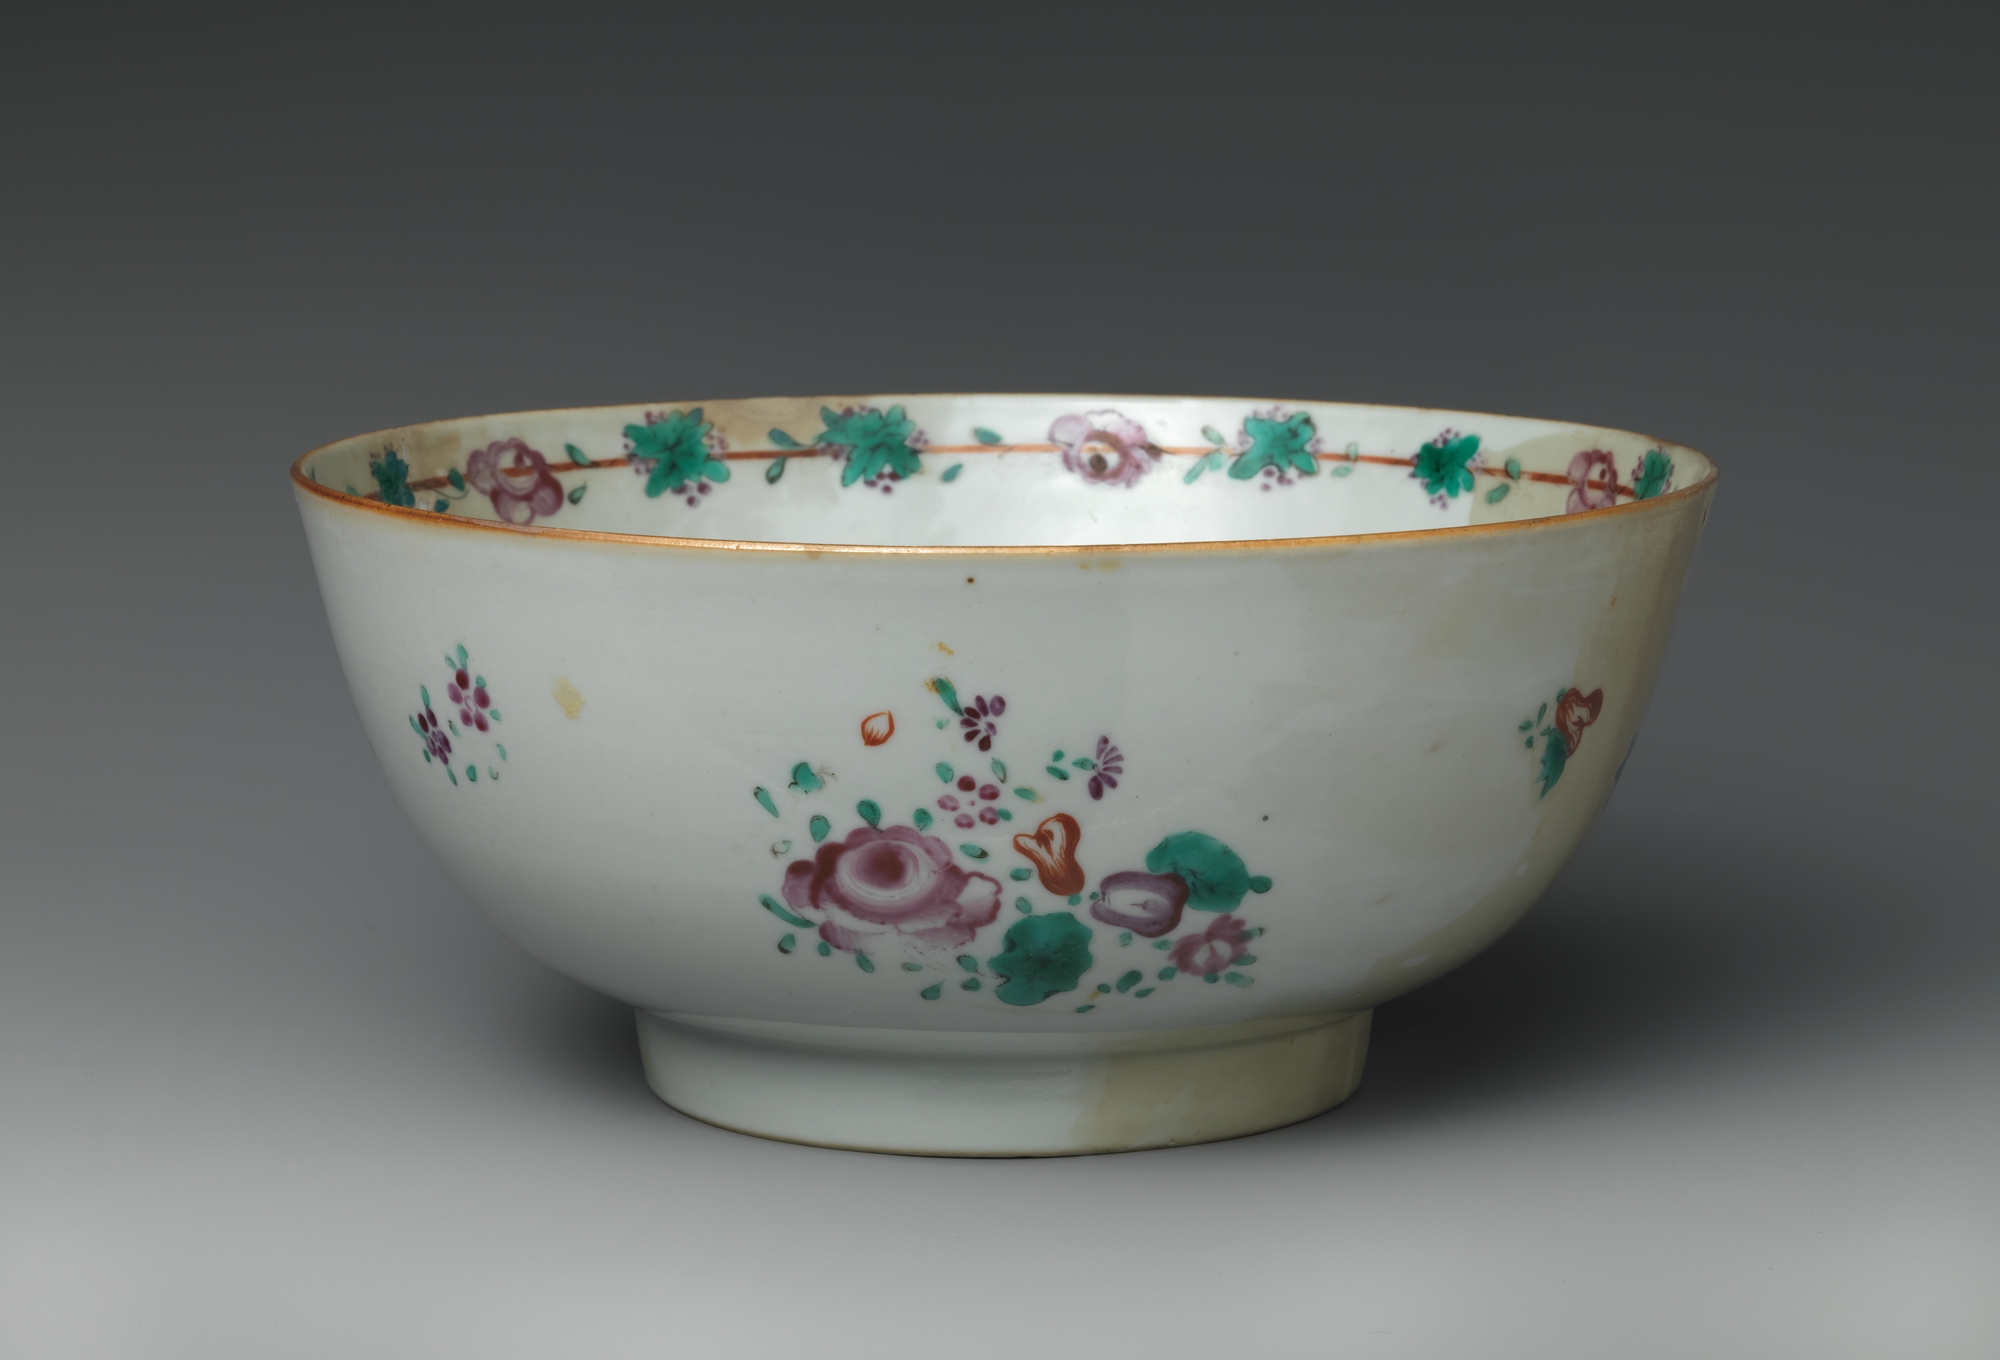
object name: bowl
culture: chinese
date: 1736-1795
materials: porcelain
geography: china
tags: flowers